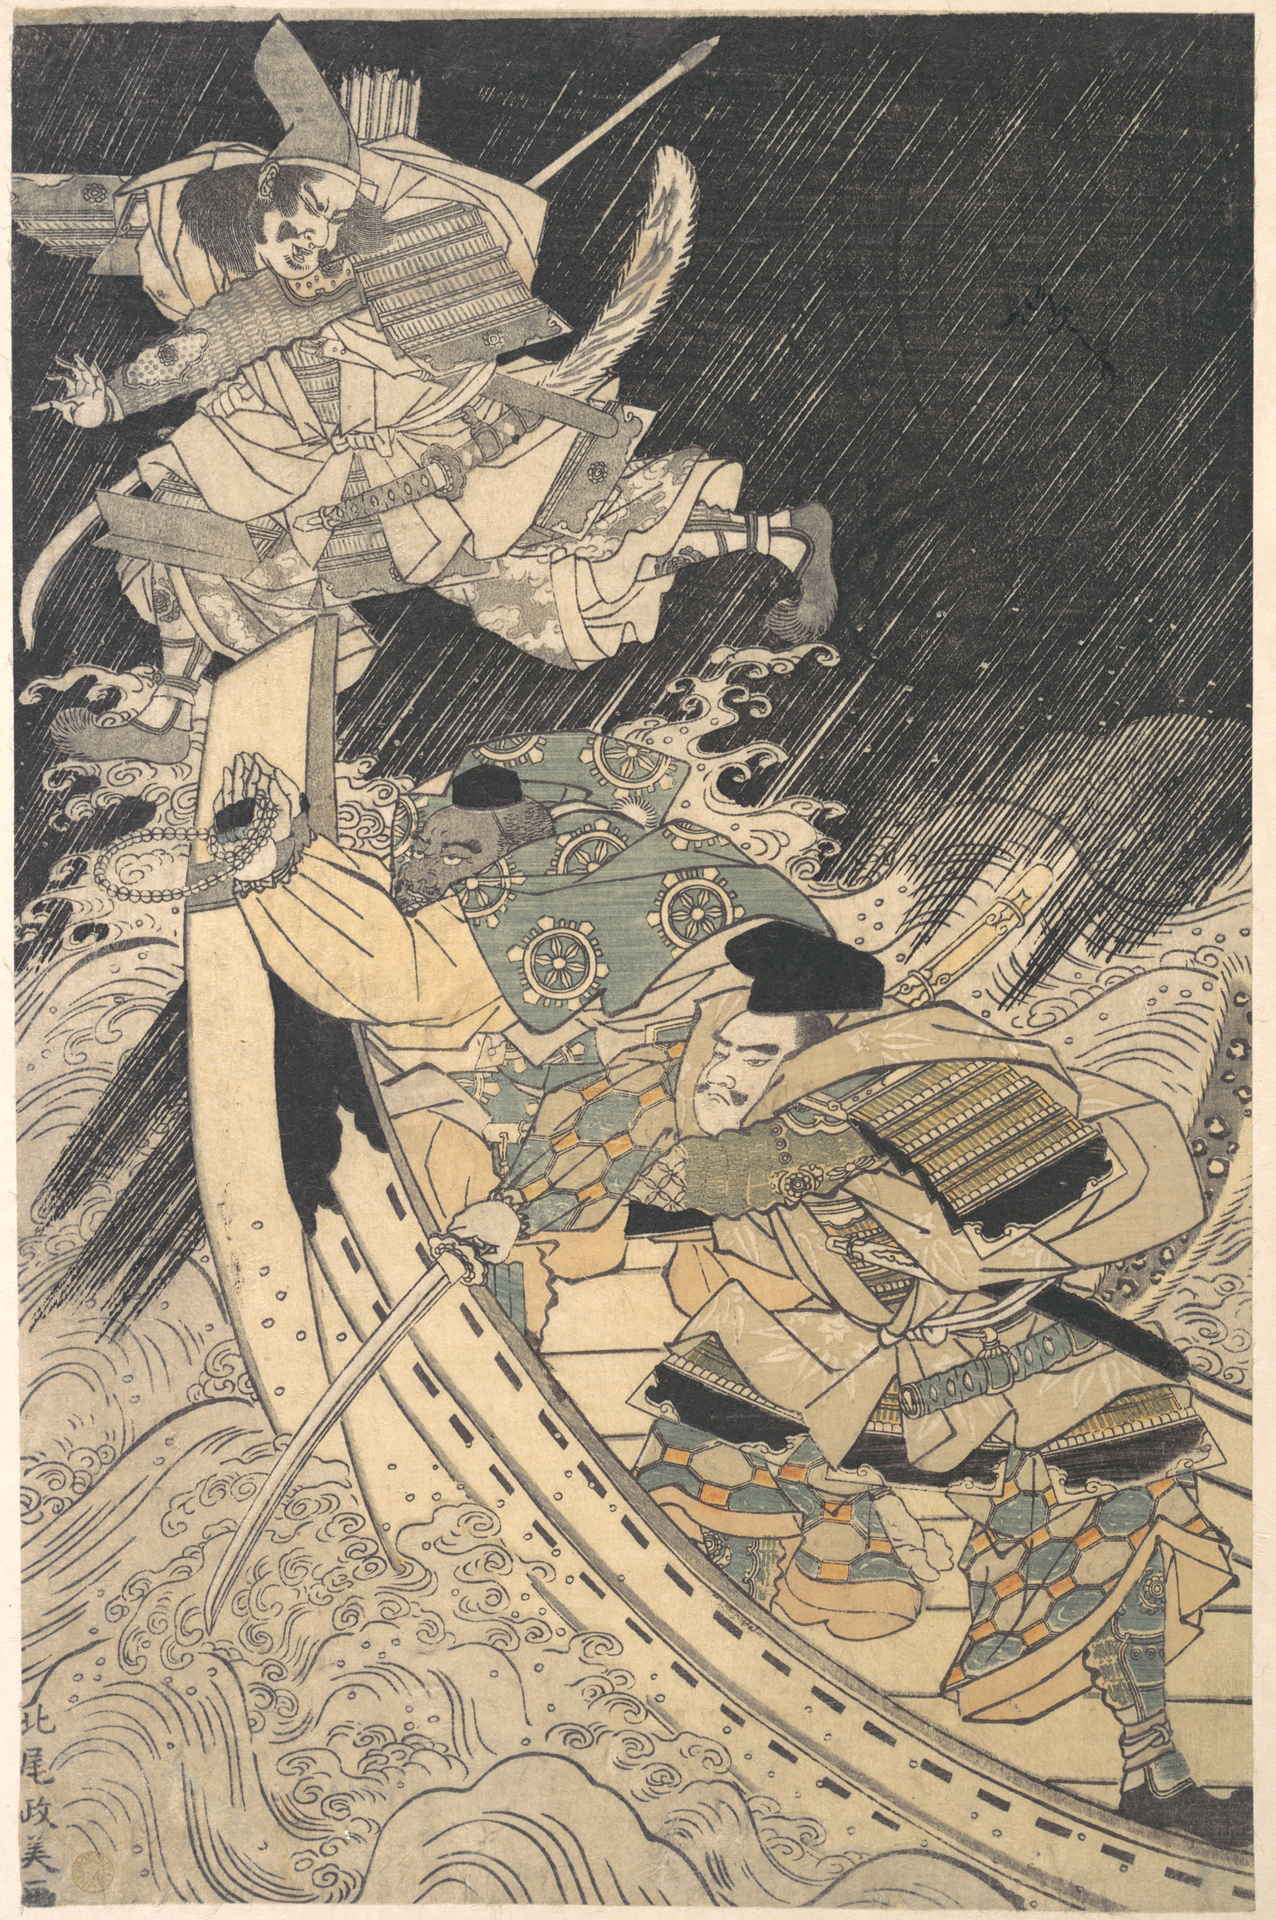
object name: print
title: Minamoto Yoshitsune and His Retainer, the Monk Benkei, Putting to Flight the Ghost of Taira no Tomomori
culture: japanese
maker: kuwagata keisai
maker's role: artist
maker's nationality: japanese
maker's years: 1764-1824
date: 1767-1800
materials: ink, paper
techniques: woodblock print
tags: swords,men,rain,storms,boats